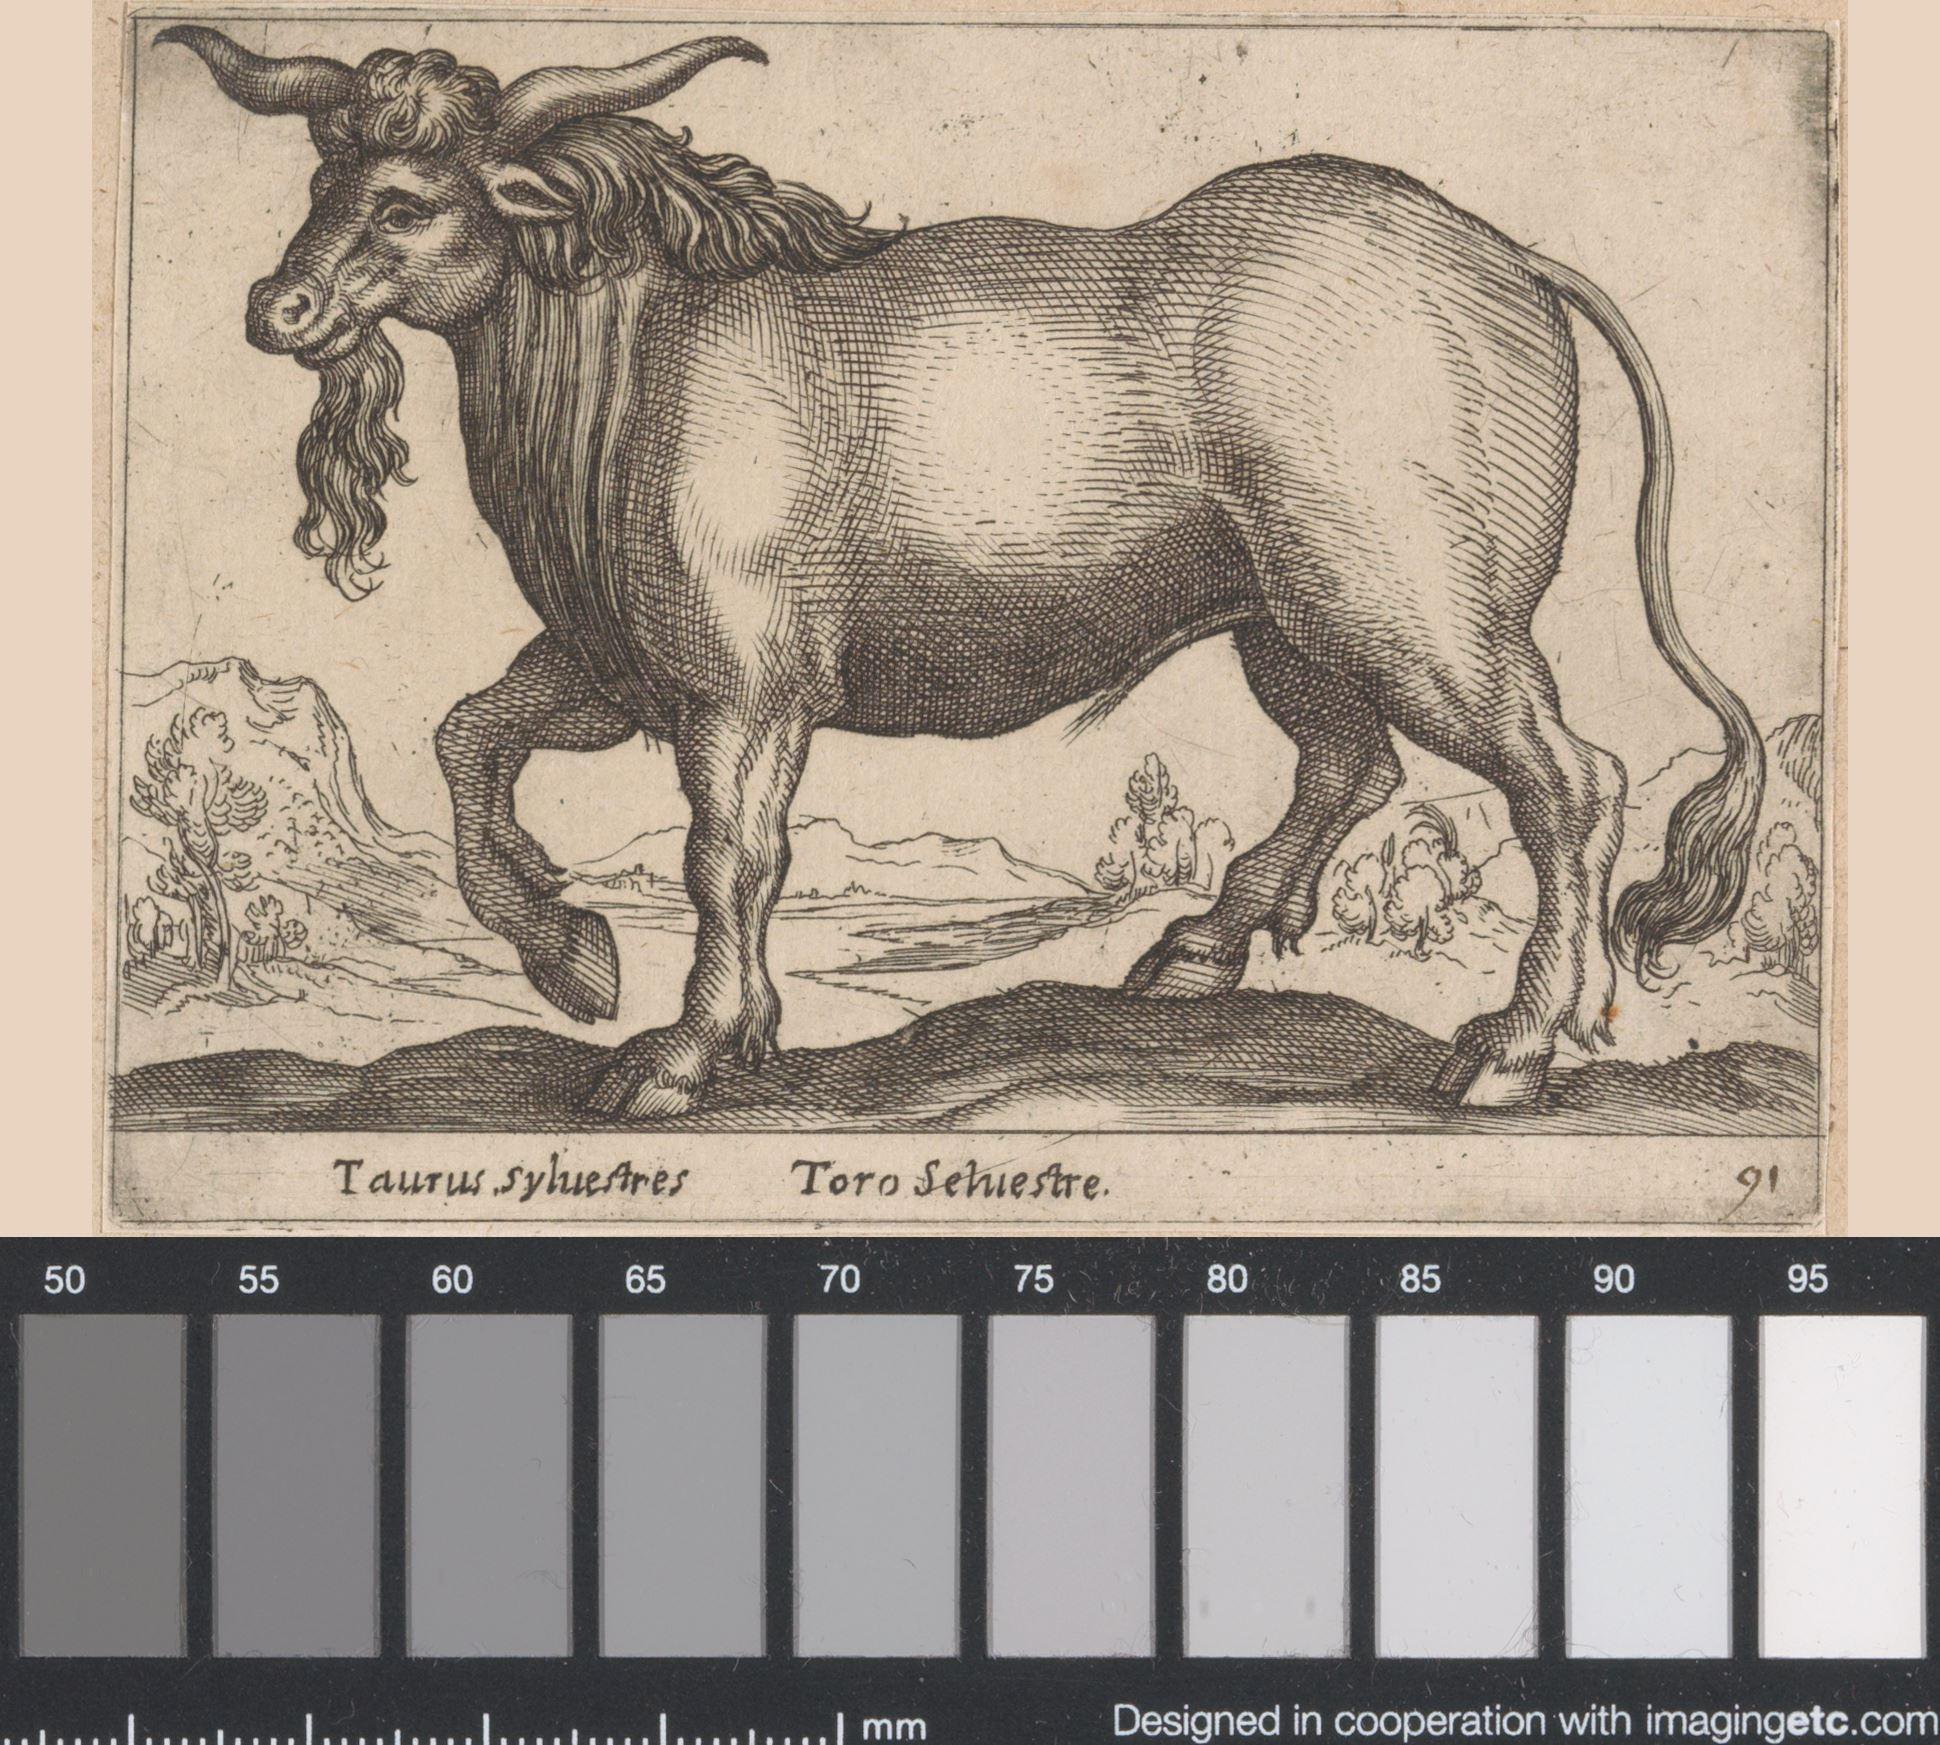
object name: print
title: Stier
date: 1565-1630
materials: paper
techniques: etching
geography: italy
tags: bull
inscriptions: collector's mark: Lugt 11, number: ‘91’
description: Deze prent maakt deel uit van een reeks prenten van dieren door Antonio Tempesta. Bekend is dat een tweede staat (met nummering) van deze serie is uitgegeven door Giovanni Giacomo de' Rossi in 1650. Onbekend is wie de eerste staat heeft uitgegeven en wanneer.